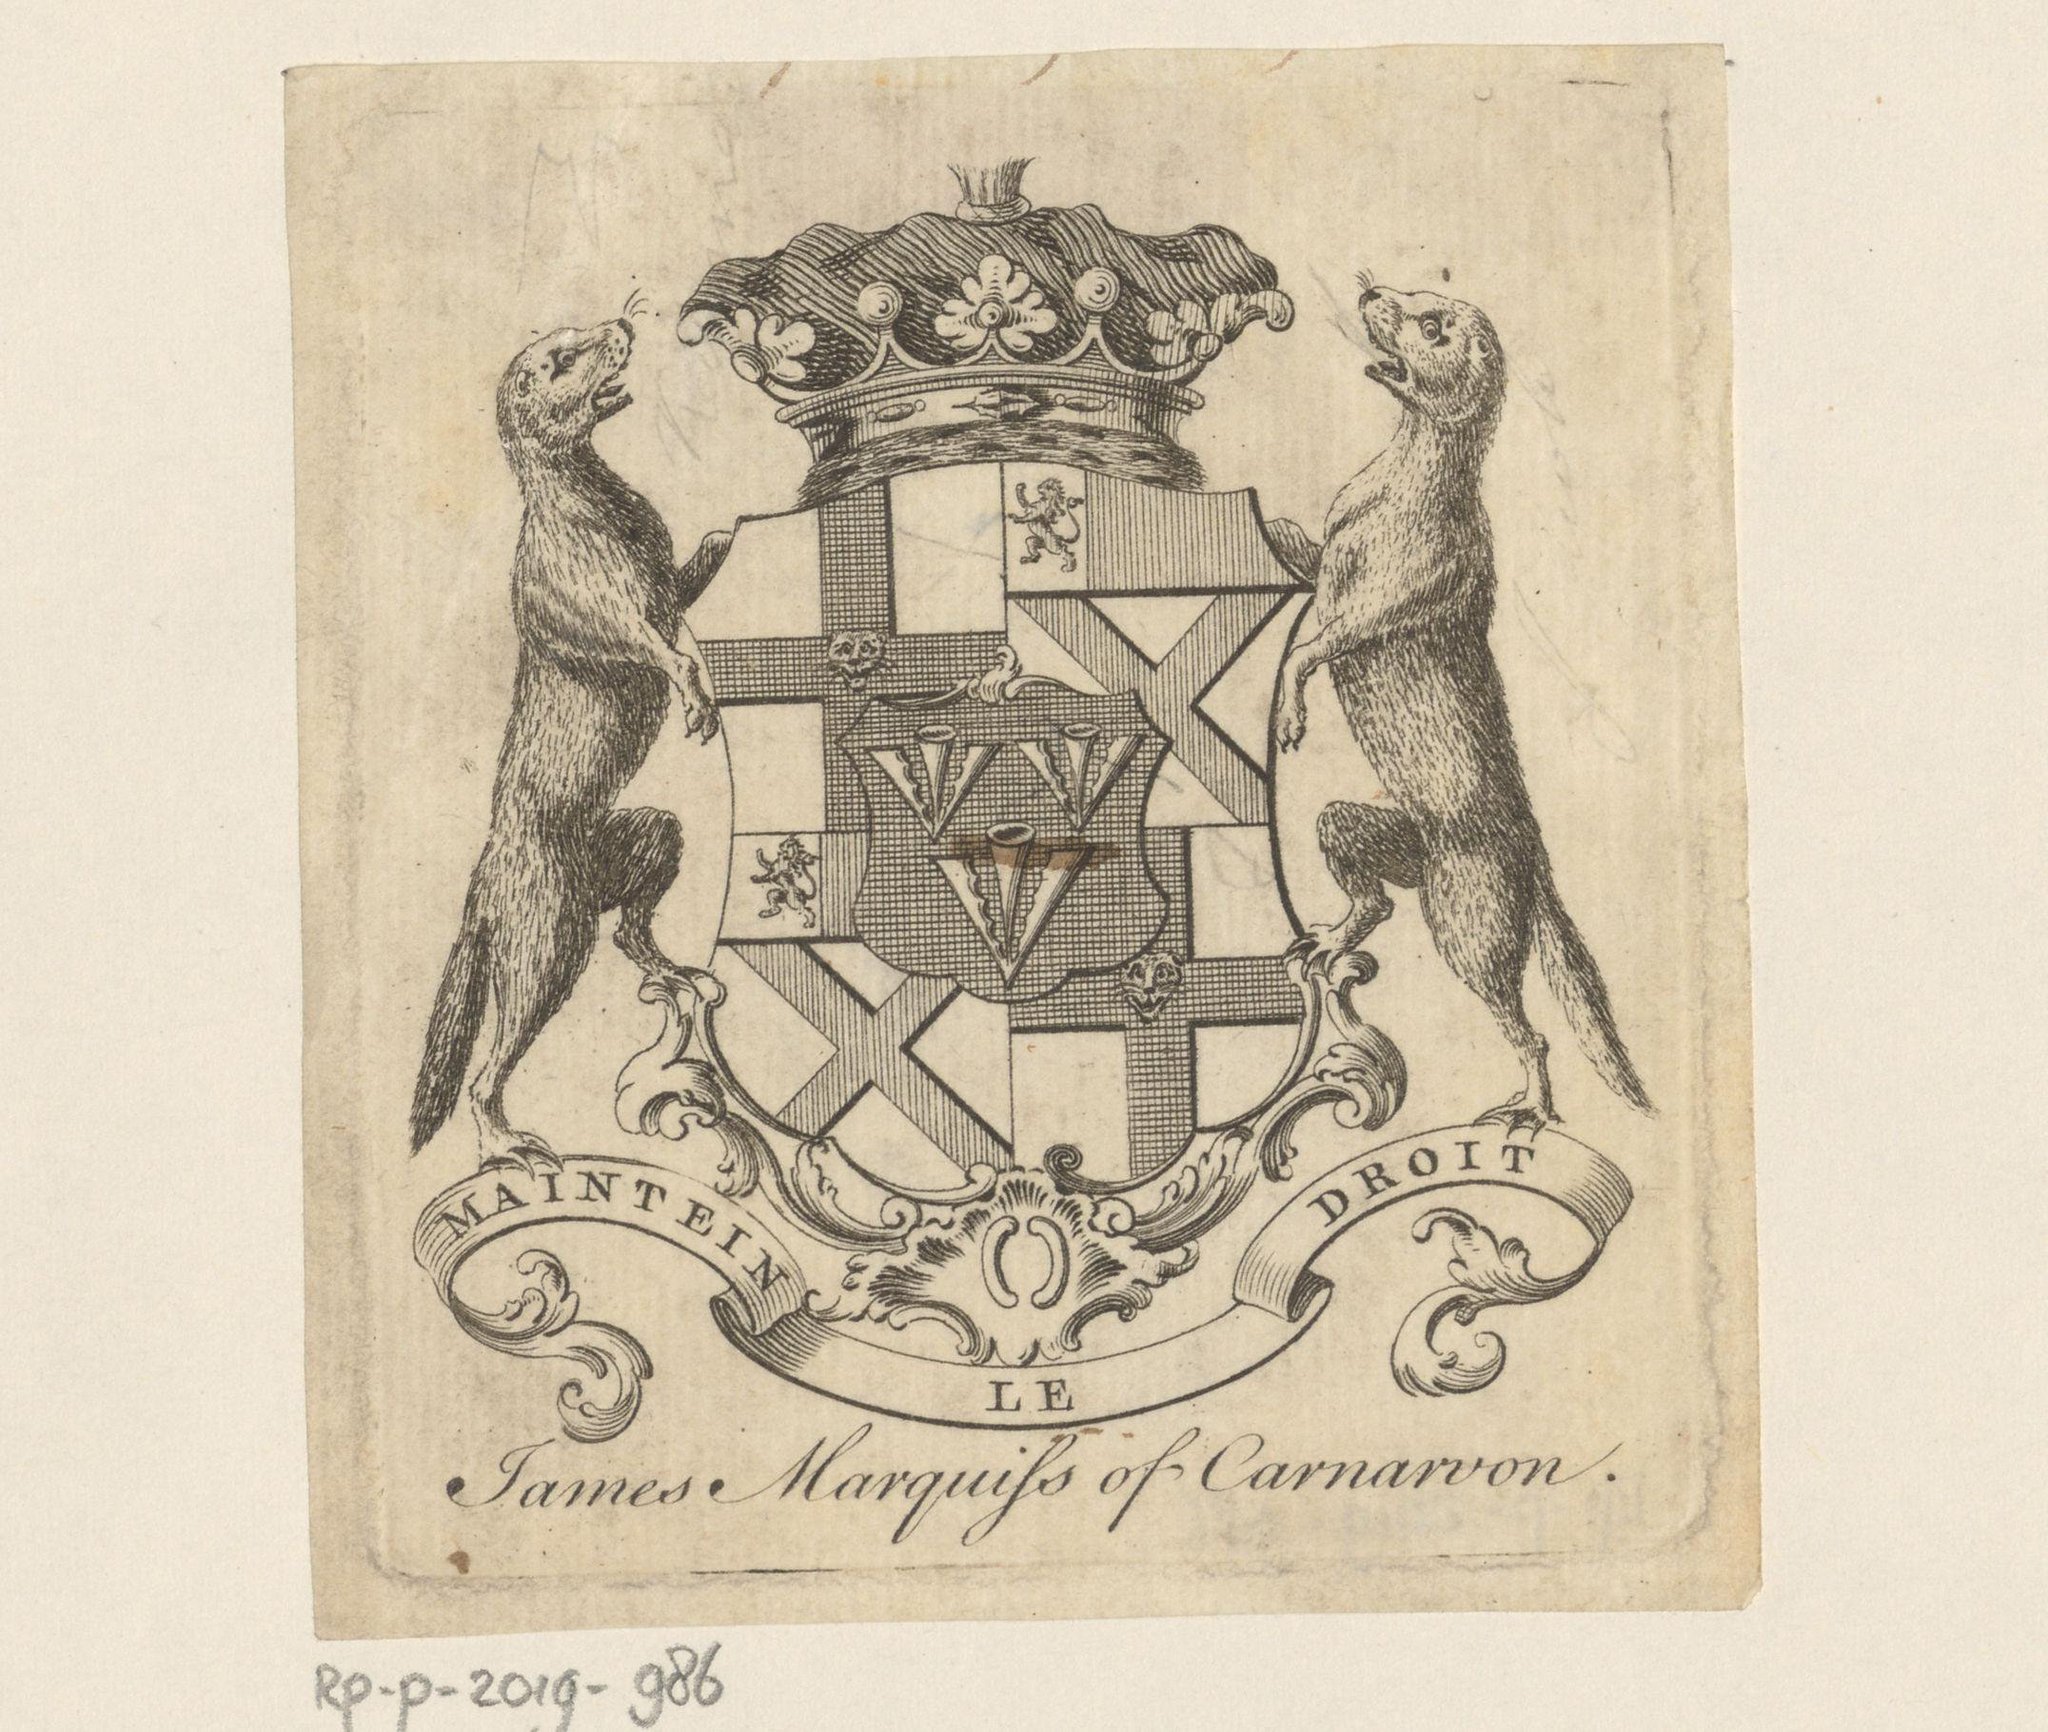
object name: bookplate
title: Ex libris van James Marquiss of Carnarvon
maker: Anonymous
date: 1700-1799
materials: paper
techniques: engraving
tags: politician, armorial bearing, heraldry